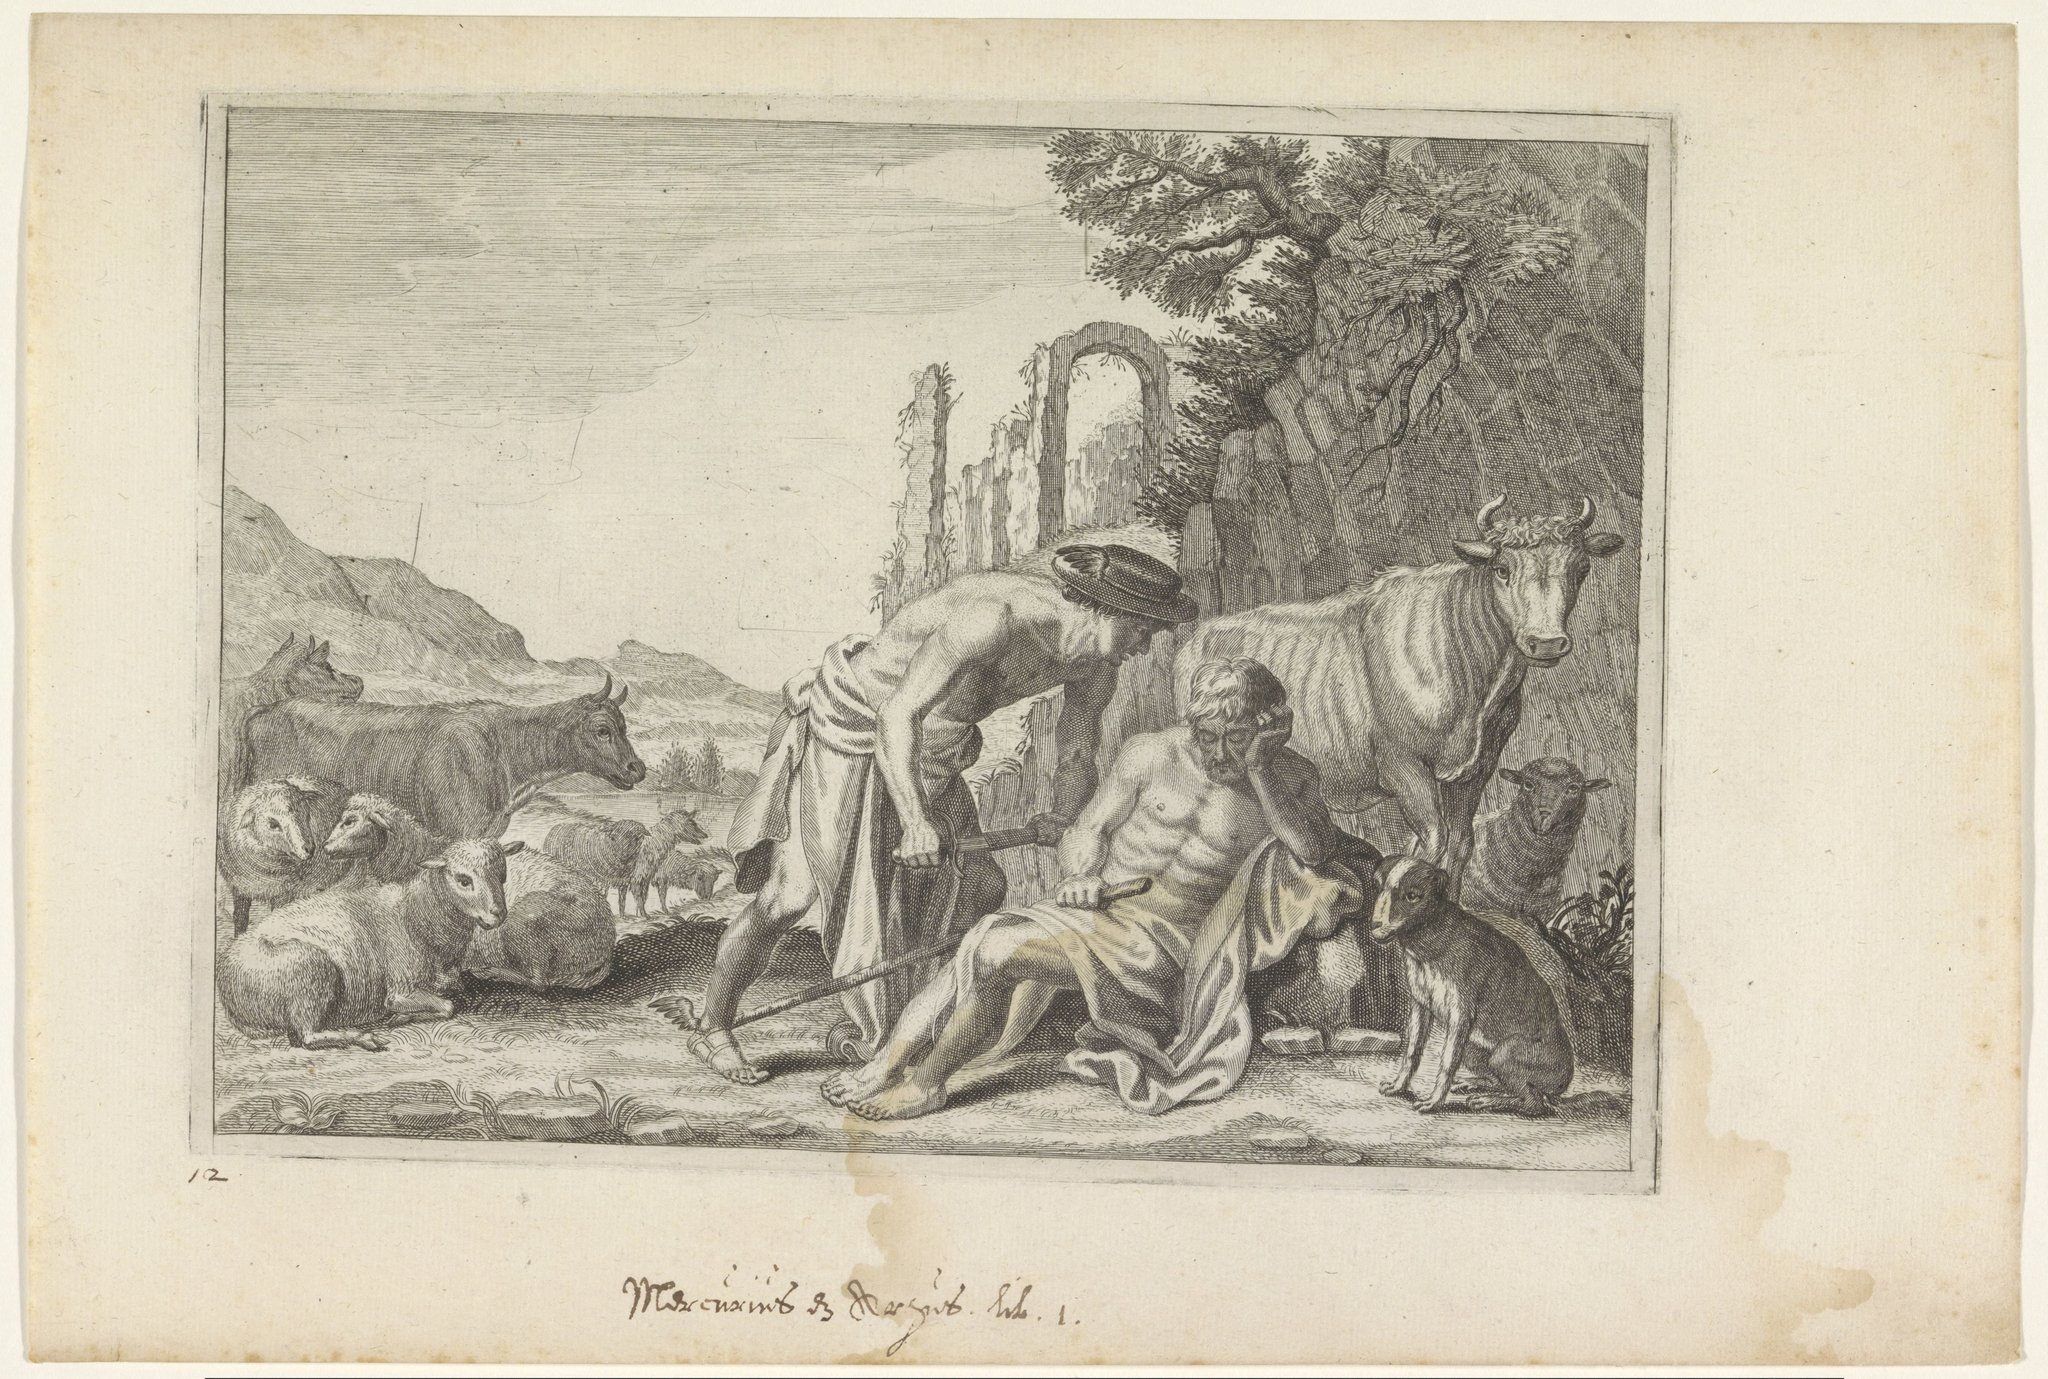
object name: print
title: Mercurius bij de slapende Argus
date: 1636-1670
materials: paper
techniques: engraving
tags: mercury lulls argus into sleep by making music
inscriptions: annotation: ‘Mercurius en Argus. lib. 1.’, number: ‘12’, collector's mark: ‘Hinloopen’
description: Deze incomplete serie, bestaande uit 77 van de in totaal 85 prenten met scènes uit Ovidius' Metamorfosen, werd in 1709 samen met Ovidius-illustraties van Tempesta, Goltzius en Le Pautre in één album, Schijnvoet nummer 43, ingebonden. In de negentiende eeuw werd deze band weer uit elkaar gehaald.